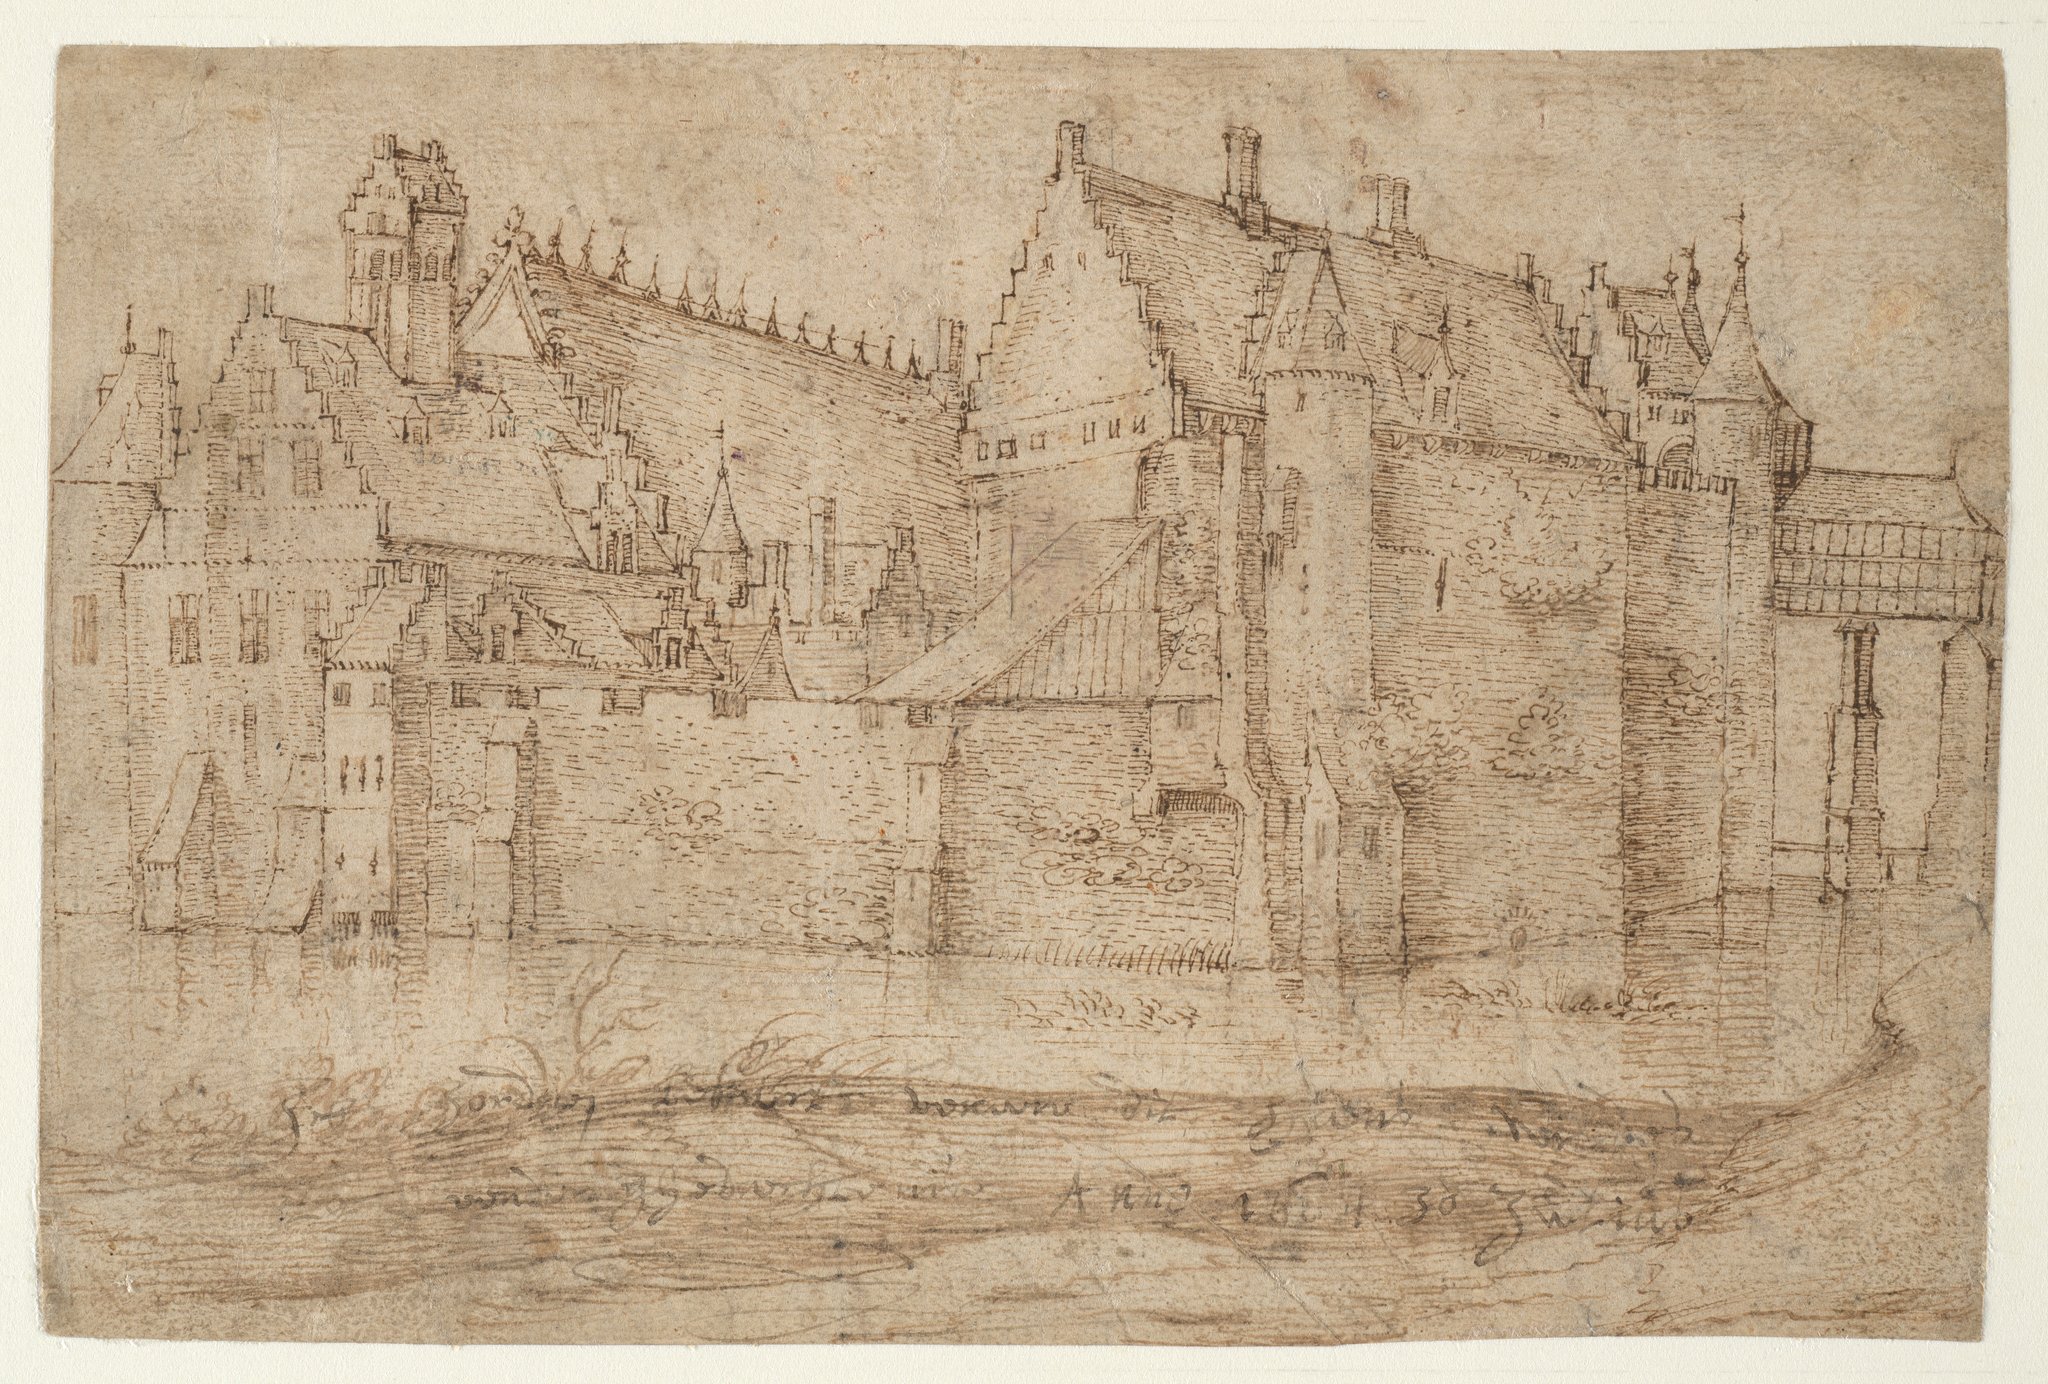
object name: drawing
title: Tervueren Castle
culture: flemish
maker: flanders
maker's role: artist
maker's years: 1604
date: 1604-1605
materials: chalk, ink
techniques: brush, pen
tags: castles